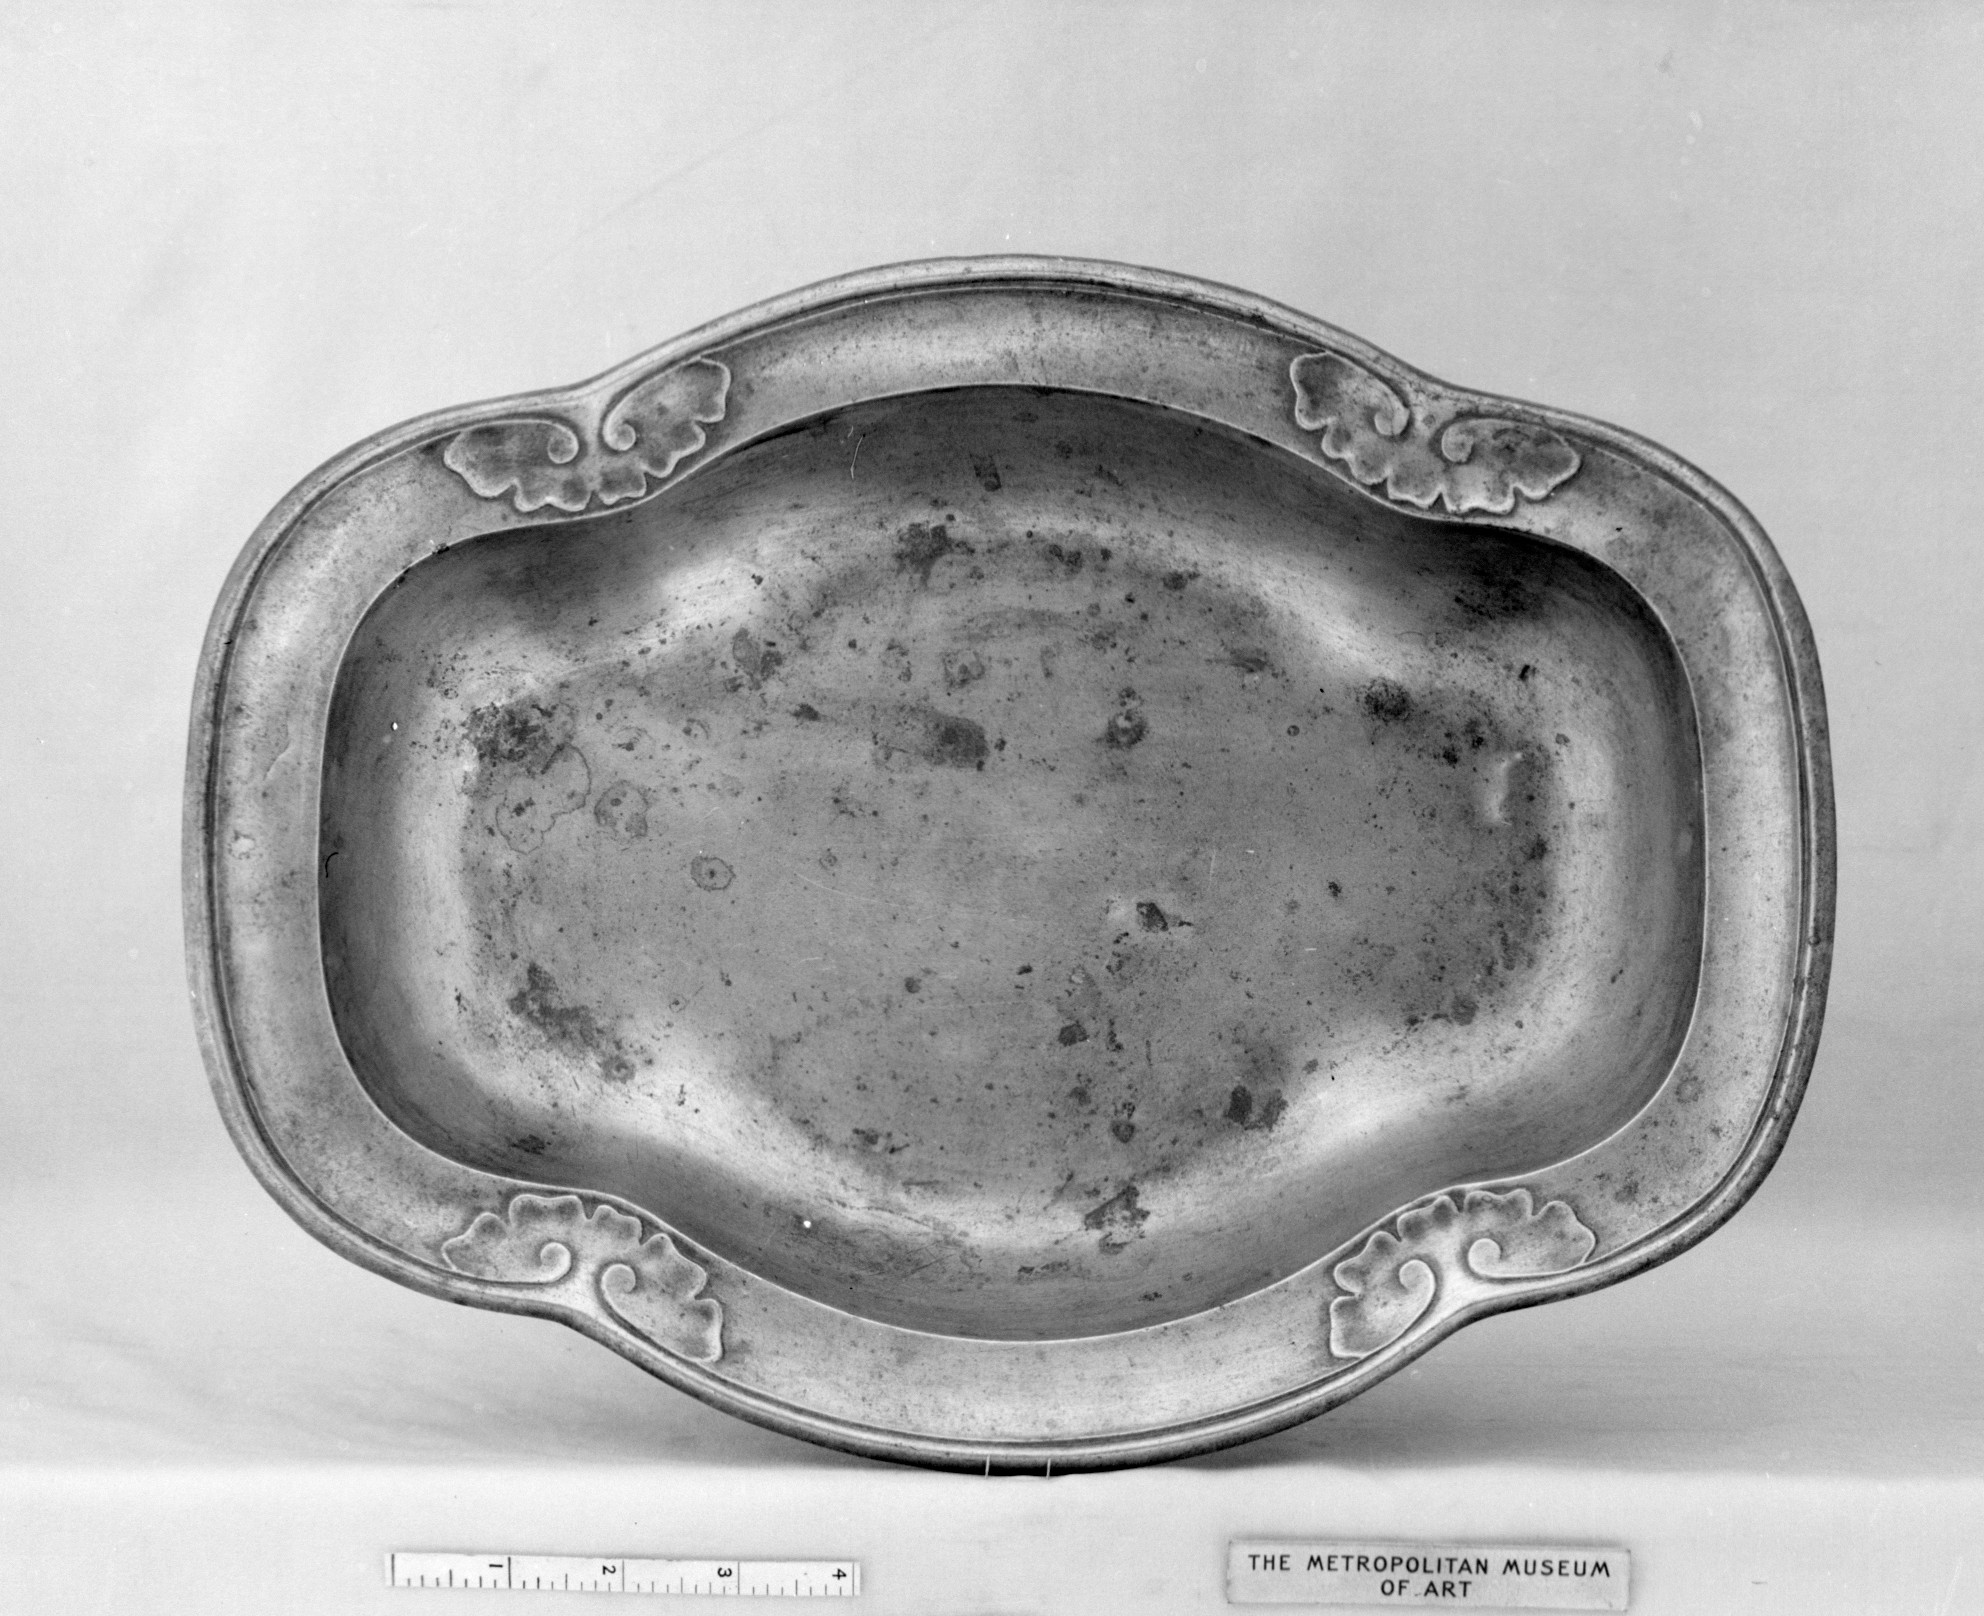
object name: basin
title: Basin (part of a set)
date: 1701-1800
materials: pewter